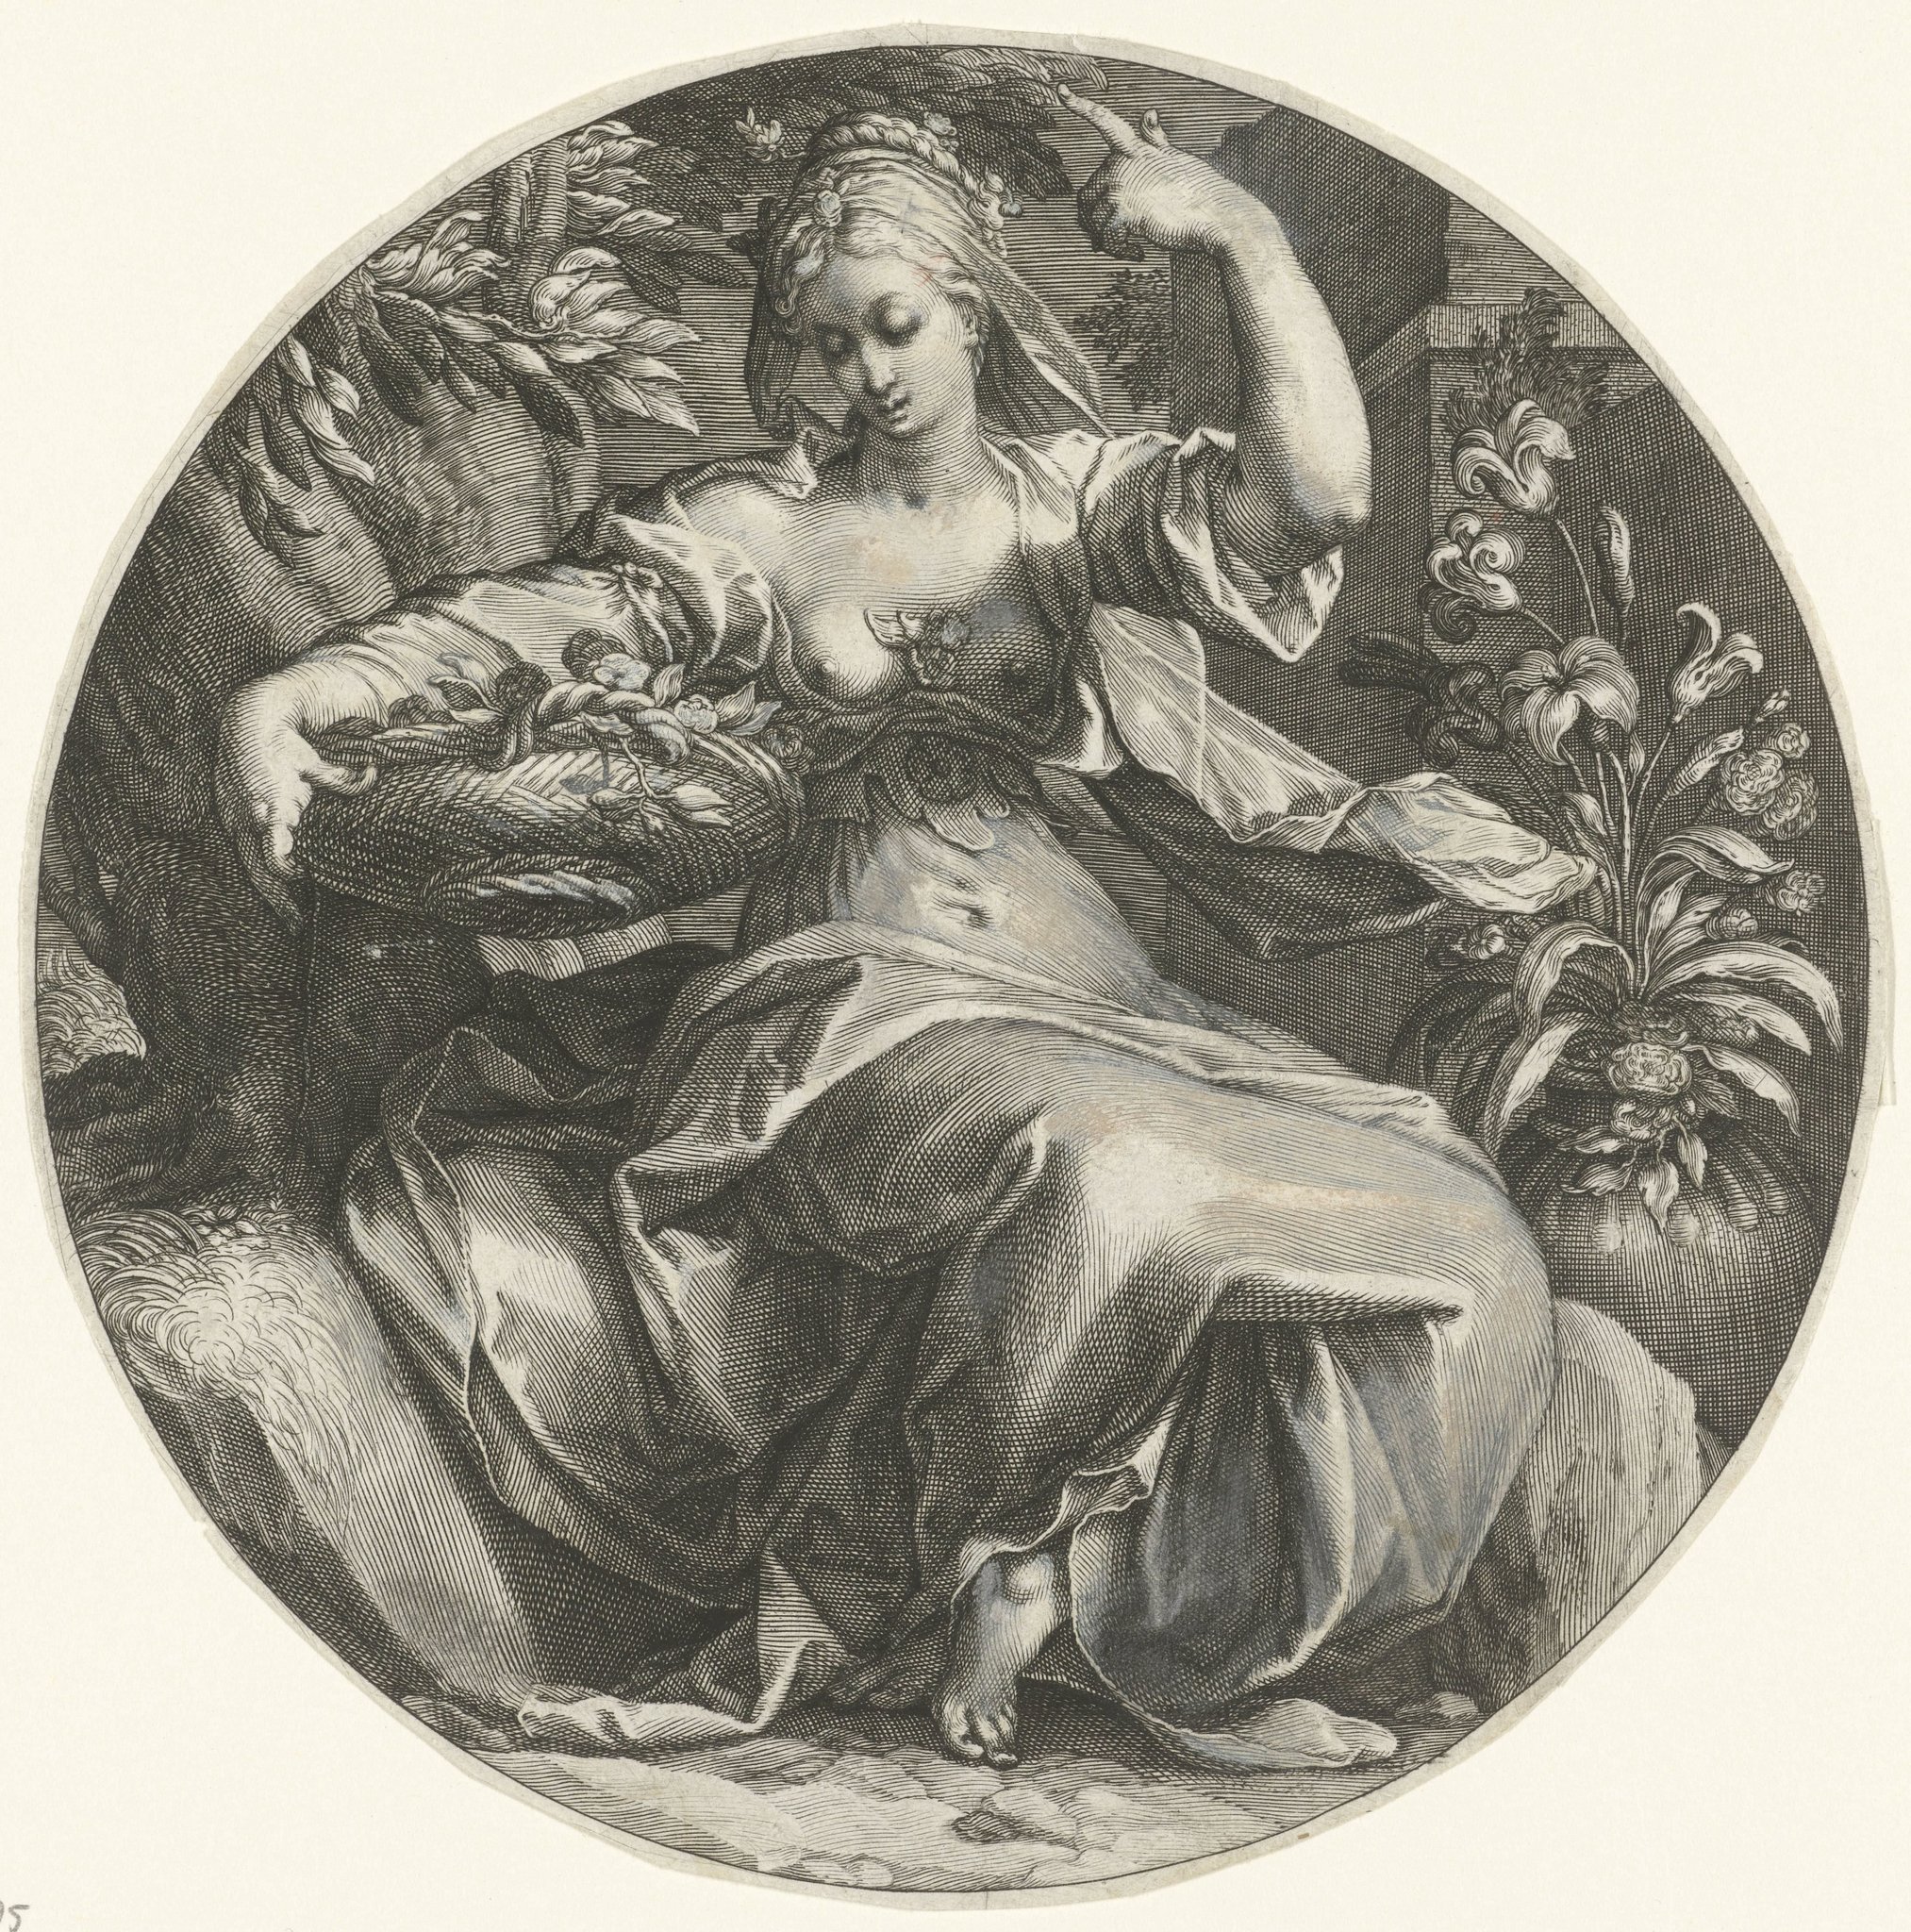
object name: print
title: Flora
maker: harmen jansz muller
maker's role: print maker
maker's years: 1540-1617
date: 1598-1602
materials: paint, paper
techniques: brush, engraving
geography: amsterdam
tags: (story of) flora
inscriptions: collector's mark: Lugt 240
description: Flora, zittend met ontblote borsten, met een mand met bloemen onder haar arm. Naast haar staat een vaas met bloemen.